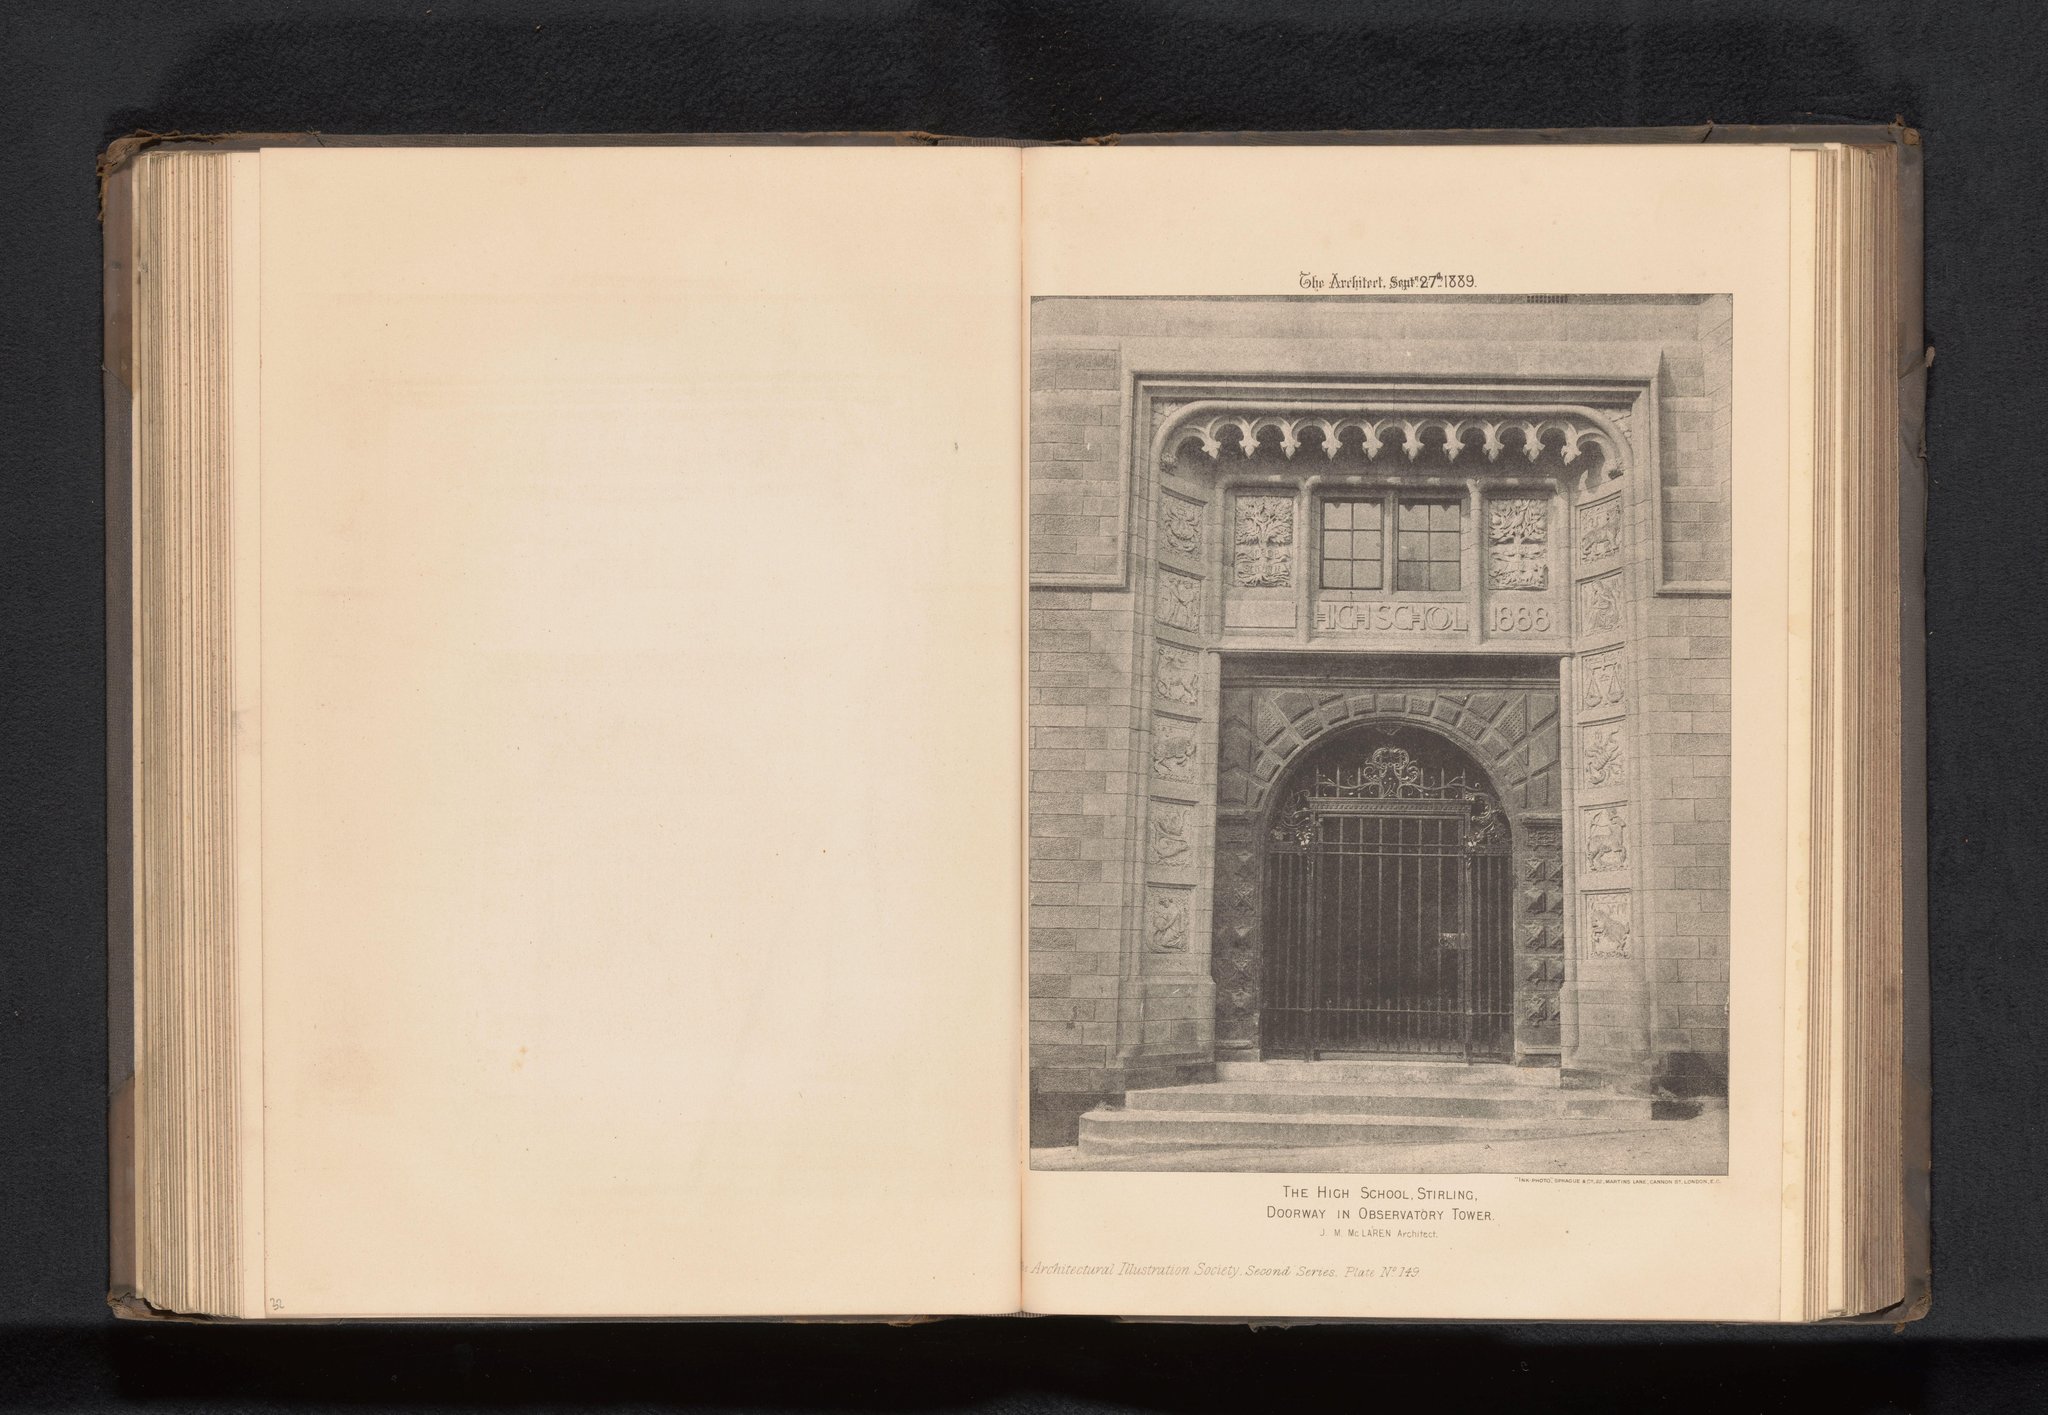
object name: page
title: The High School, Stirling, Doorway in Observatory Tower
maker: Anonymous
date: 1884-1889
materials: paper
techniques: photolithography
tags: secondary education, gate, entrance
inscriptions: inscription: ‘J.M. Mc Laren Architect/ Architectural Illustration Society. Second Series. Plate No.149’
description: Prent op elfde ongenummerde pagina na pagina 178.